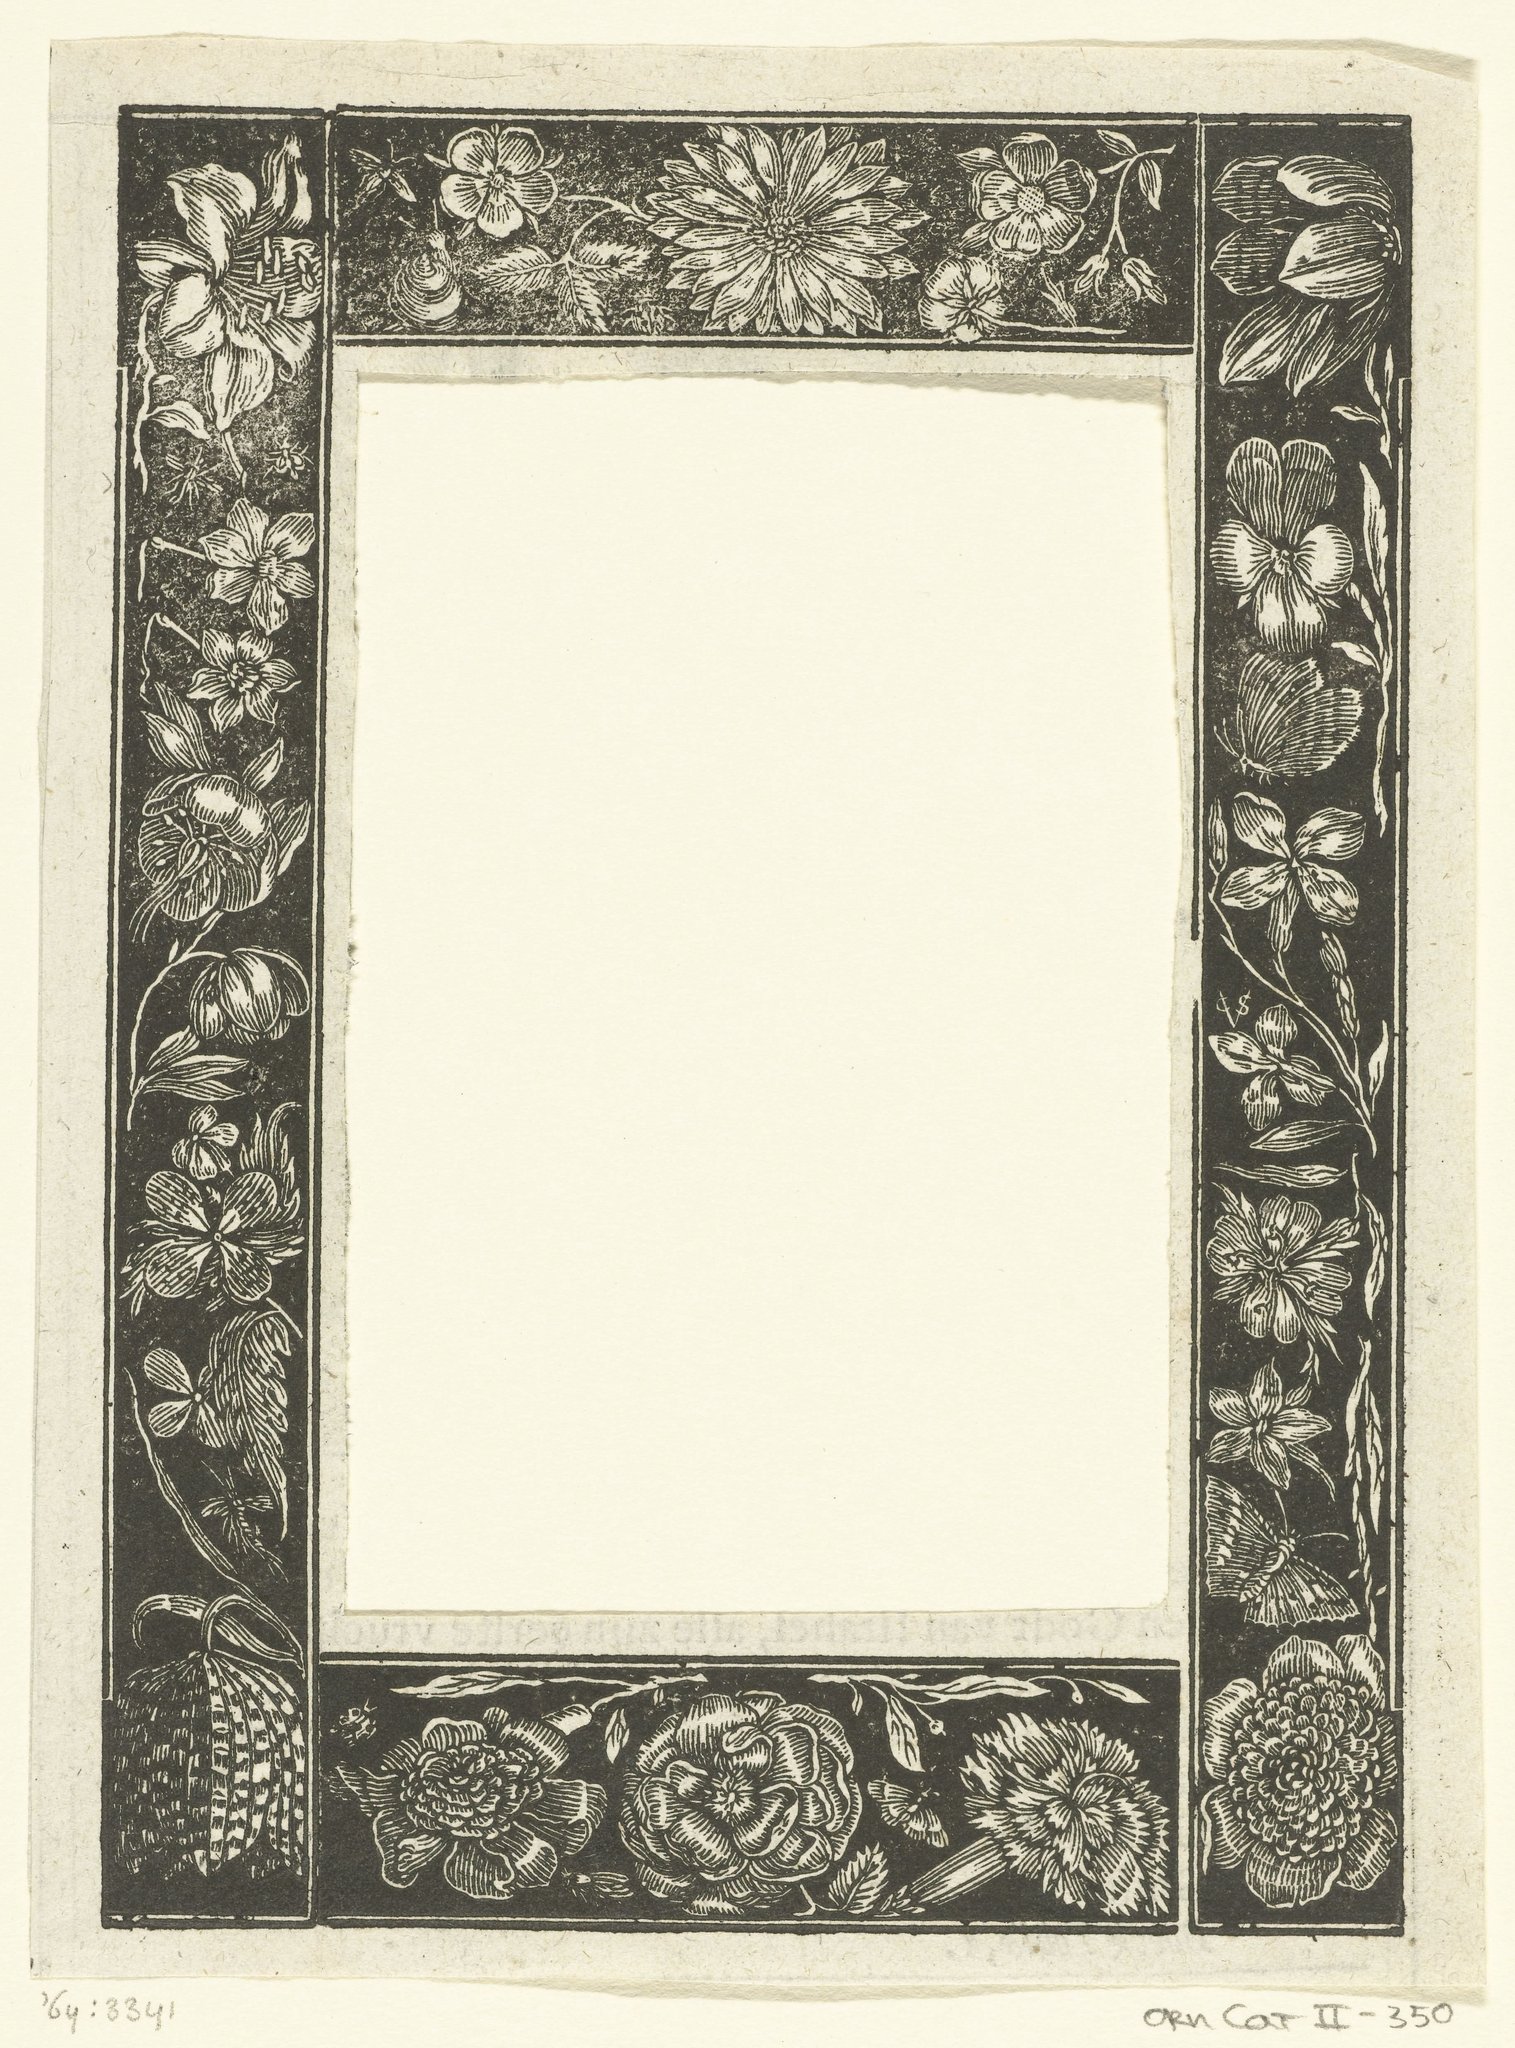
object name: ornament print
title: Lijsten met bladranken, kandelabermotieven, vazen met bloemen en bloemen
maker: Anonymous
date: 1646-1657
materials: paper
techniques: woodcut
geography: amsterdam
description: Omlijsting gedrukt van vier houtblokken. Zowel de panelen als de friezen zijn gedecoreerd met bloemen. De lijsten zijn grotendeels varianten of kopieën naar laat zestiende eeuwse Franse en Vlaamse prenten. Alle omlijstingen werden gebruikt om een Bijbel te illustreren.